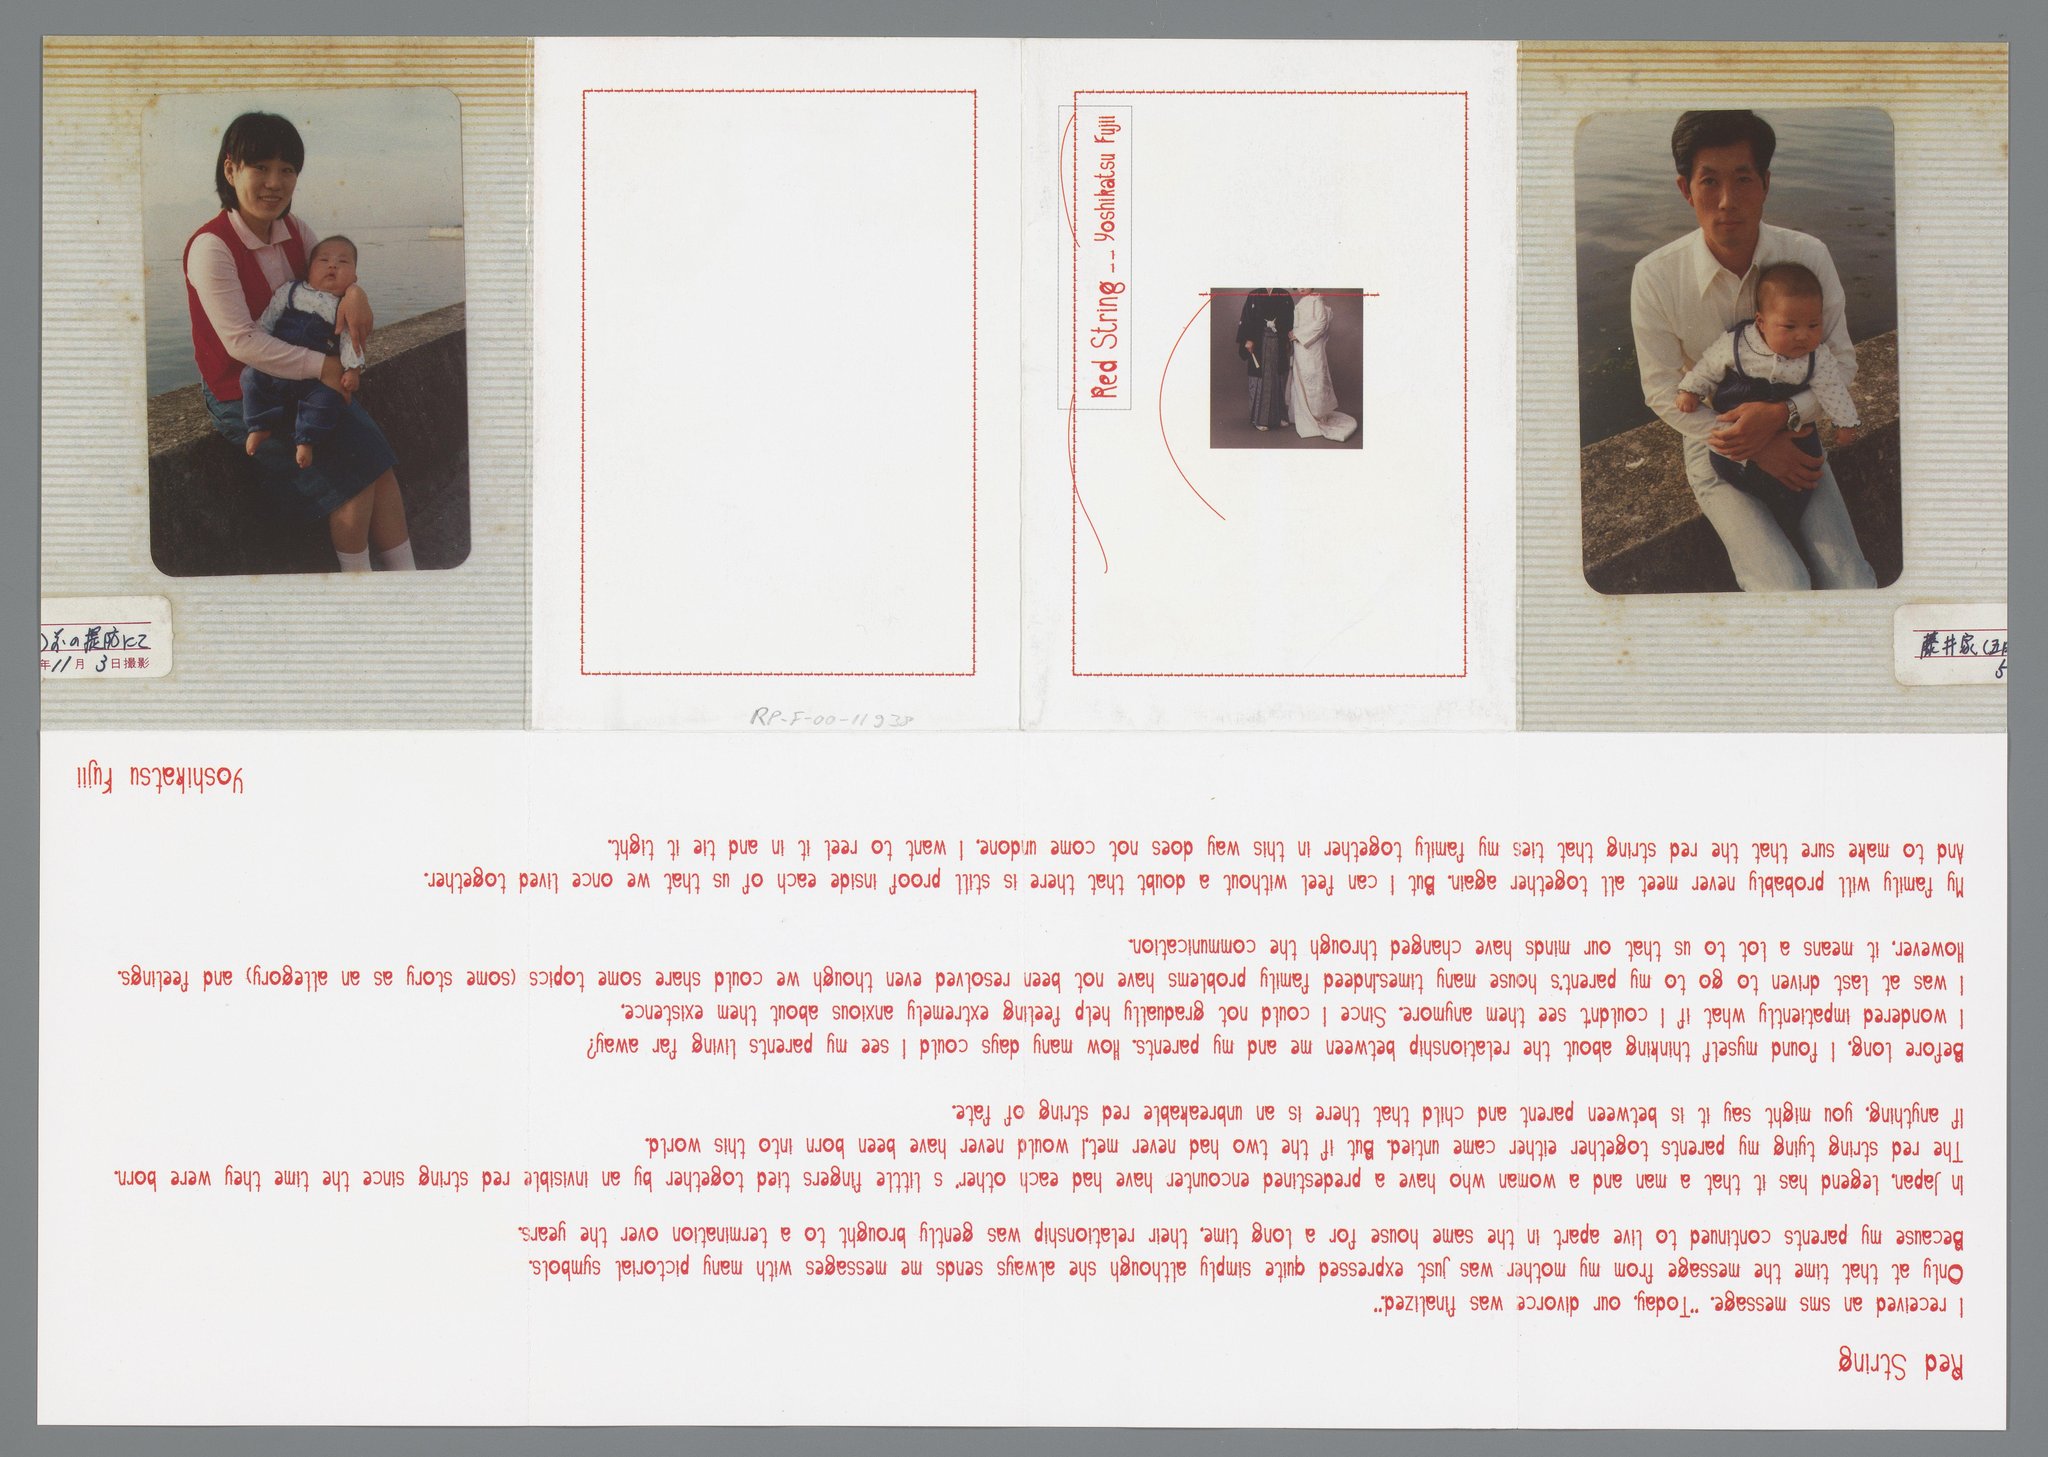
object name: photograph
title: Red string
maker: yoshikatsu fujii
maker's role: fotograaf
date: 2016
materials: paper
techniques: inkjet print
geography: tokyo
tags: family, descendance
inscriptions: inscription: ‘Red String/ I received an sms message. (...)’, inscription: ‘Red String _ Yoshikatsu Fujii_ _ _ www.yoshikatsufujii.com’